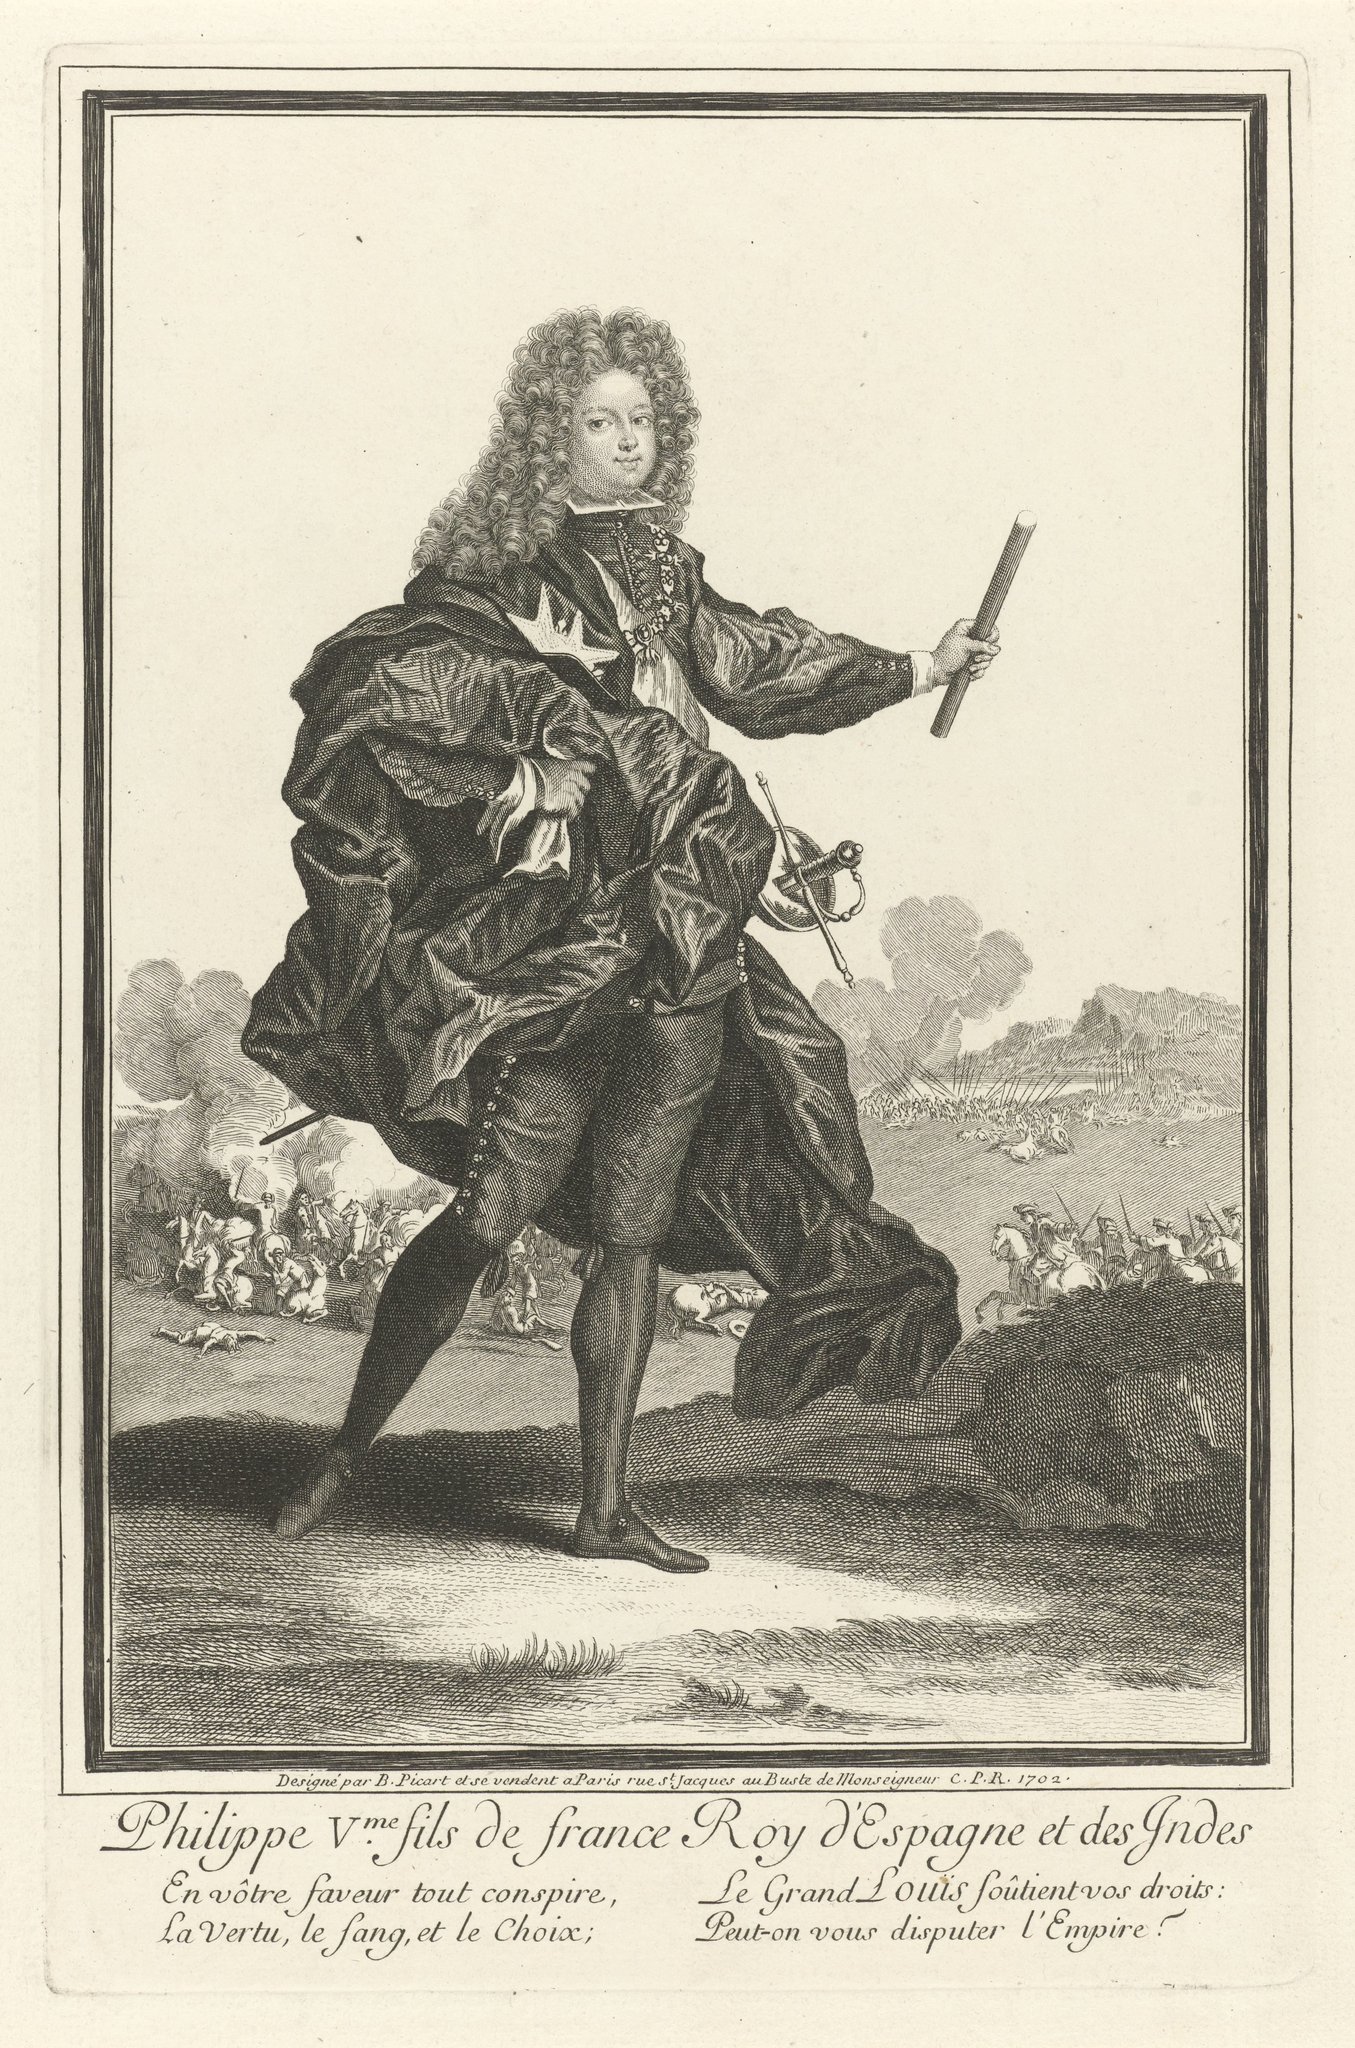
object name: costume print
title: Portret van Filips V van Spanje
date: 1702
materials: paper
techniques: engraving, etching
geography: paris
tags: filips v (koning van spanje), styles of hairdress (allonge), historical persons, battle, knighthood order of the golden fleece, clothes, costume (+ men's clothes), baton of general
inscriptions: signature: ‘Desiiné par B. Picart’, poem: ‘En votre faveur tout conspire, / La Vertu, le sang, et le Choix / Le Grand Louis soutient vos droits: / Peut-on vous disputer l'Empire.’, date: ‘1702’, address: ‘se vendent a Paris rue Stl. Jacques au Buste de Monseigneur’, collector's mark: Lugt 2228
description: Portret van Filips V, koning van Spanje. Hij draagt een keten met de Orde van het Gulden Vlies en houdt een commandostaf in de hand. Op de achtergrond een landschap met een veldslag. In de marge een vierregelig gedicht, in twee kolommen, in het Frans.